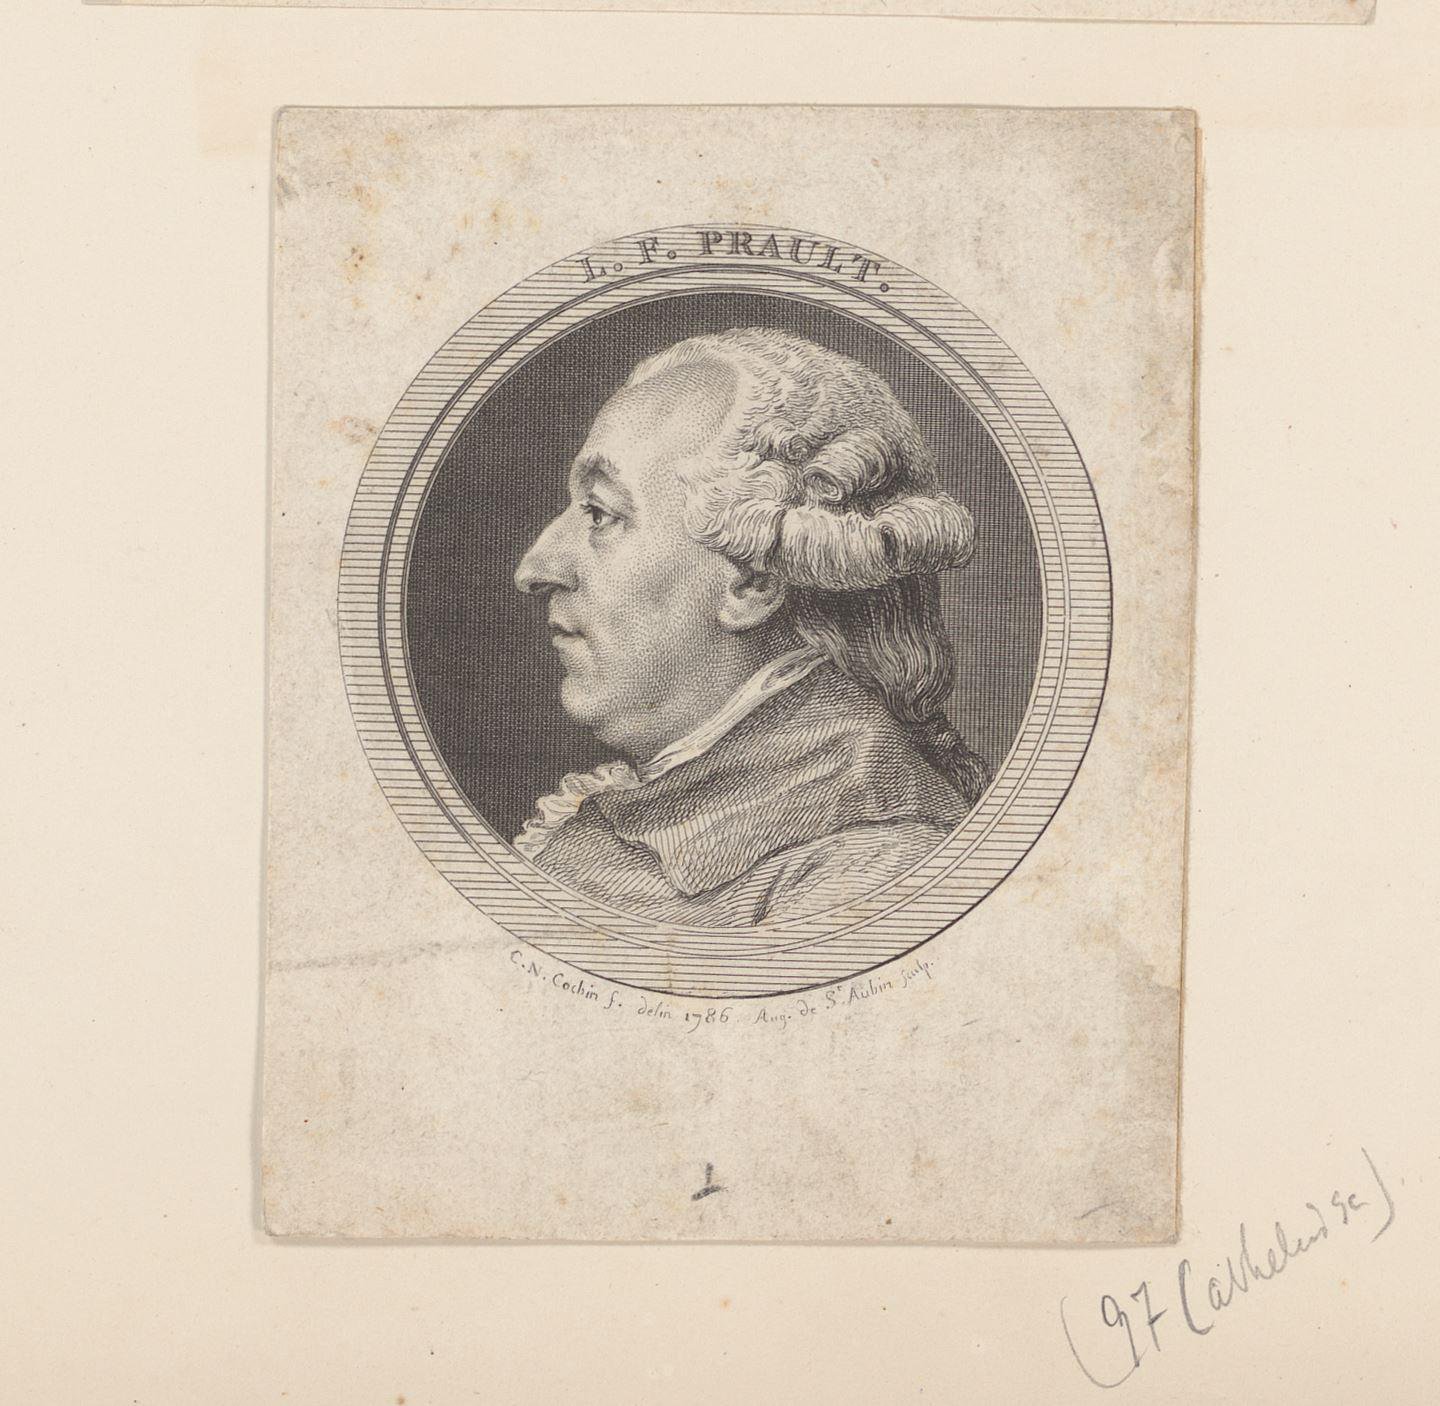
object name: print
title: L. F. Prault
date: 1787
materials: paper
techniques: engraving, etching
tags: publisher, louis-françois prault, historical persons, publishing, publisher